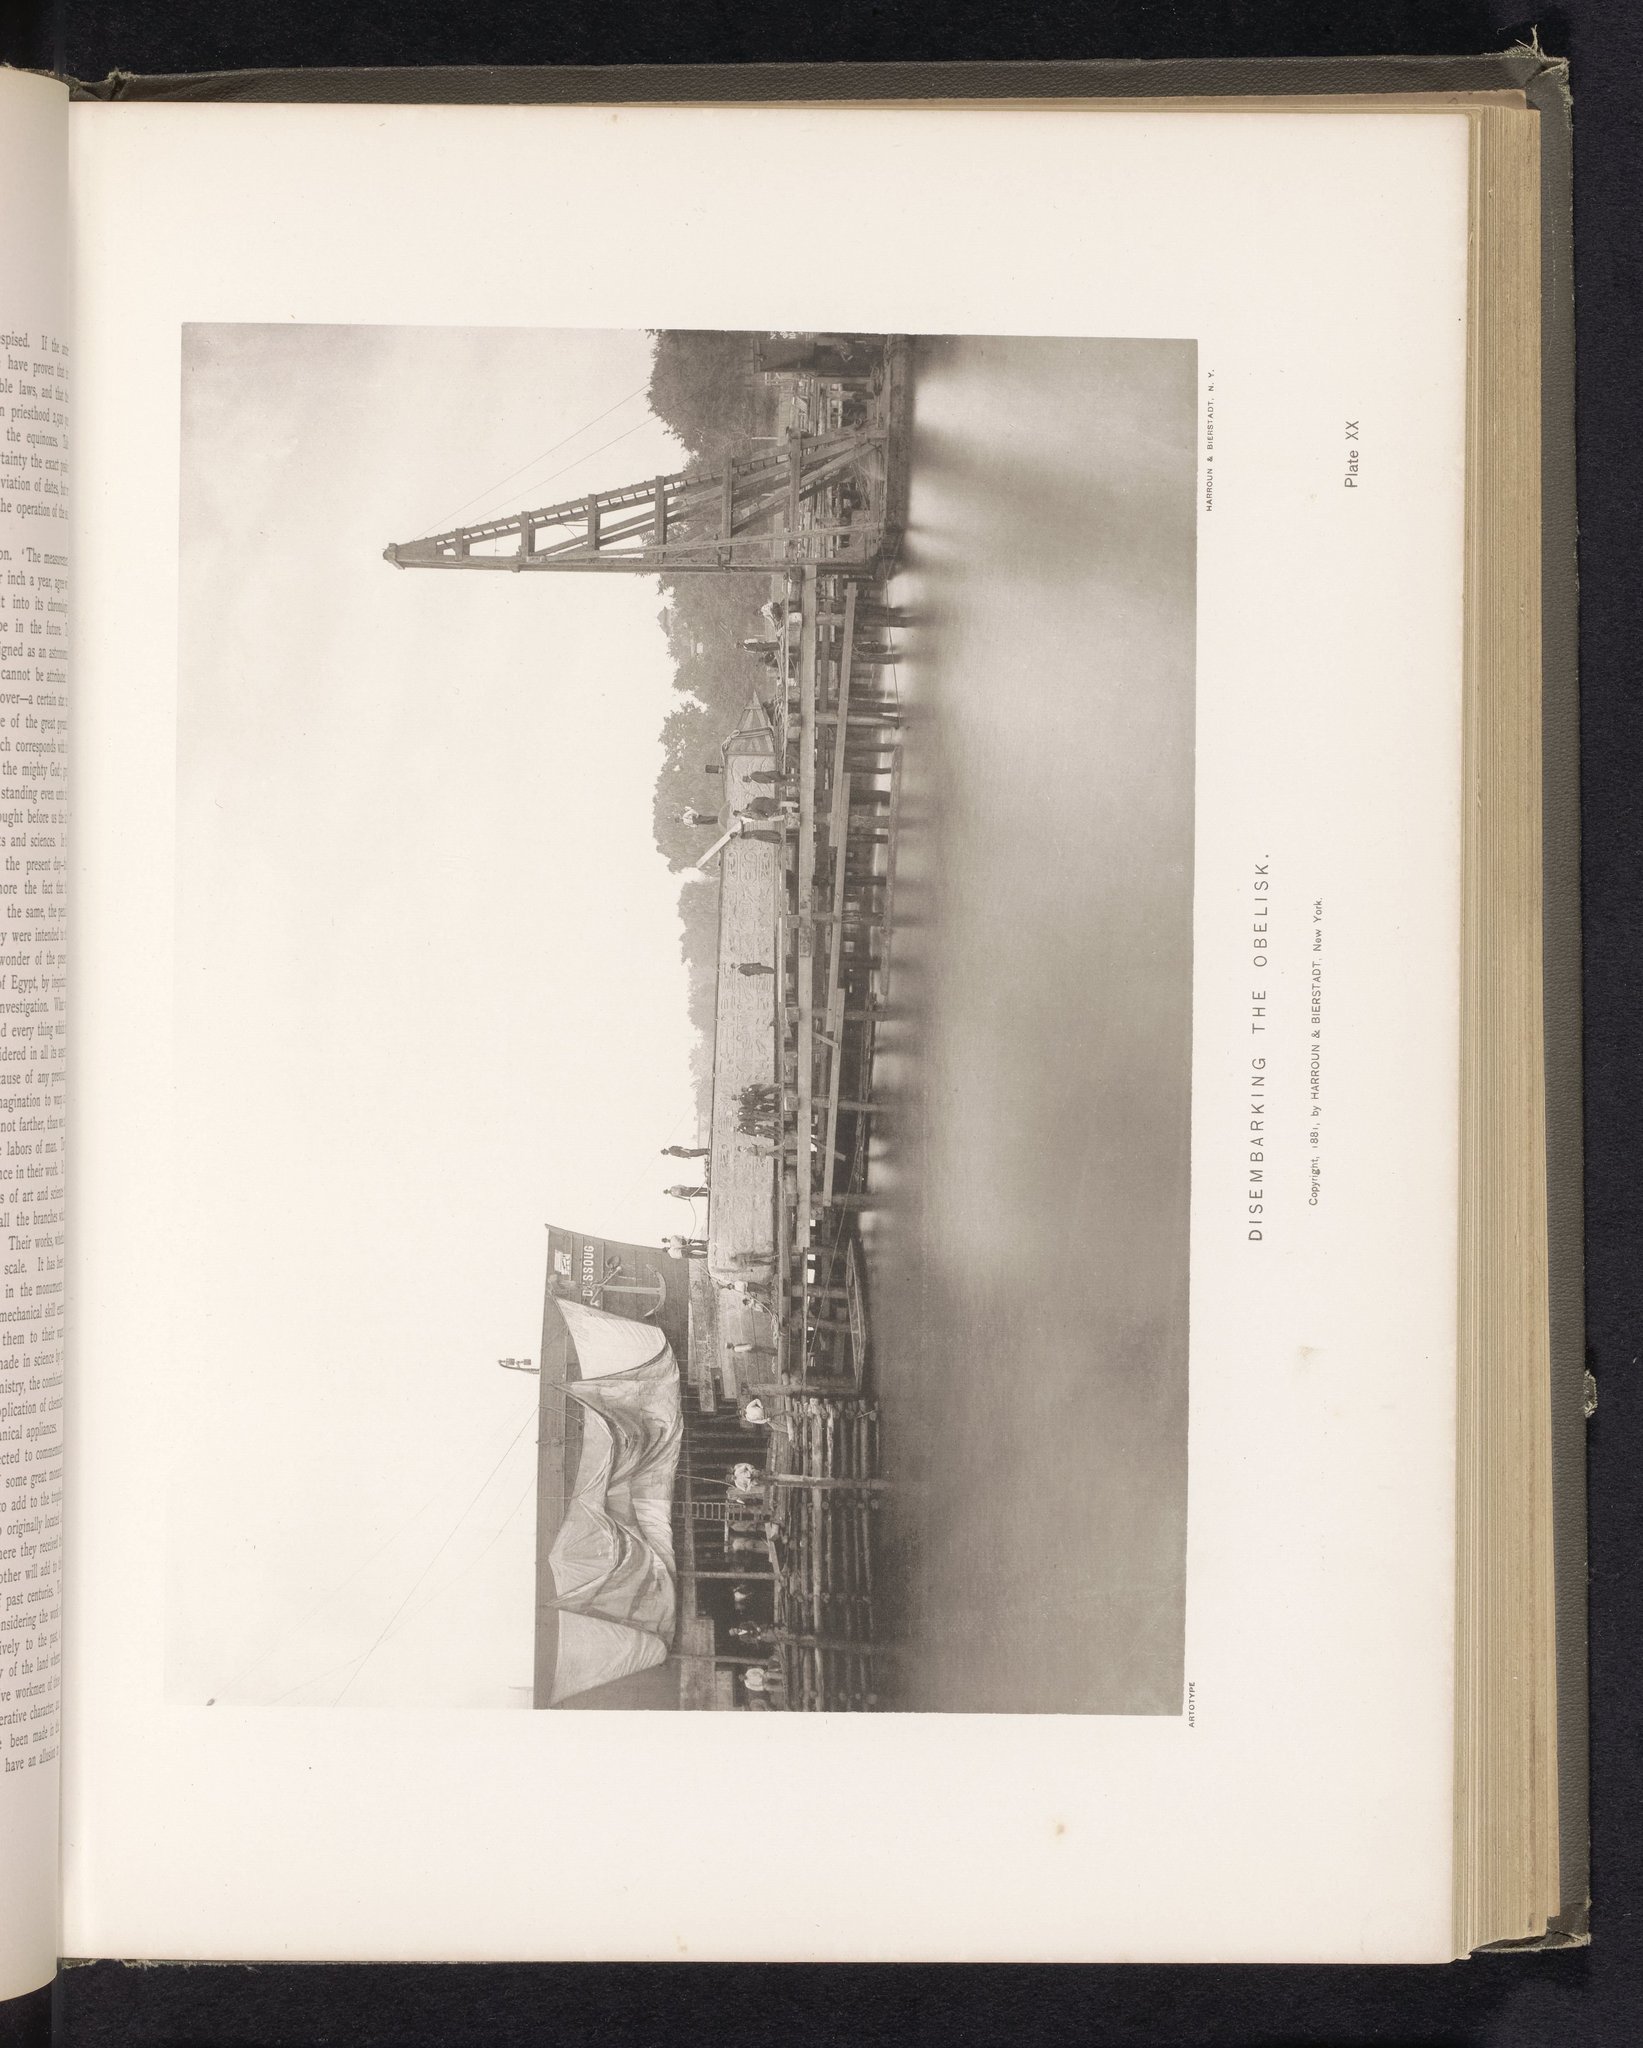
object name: photomechanical print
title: Disembarking the obelisk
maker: Anonymous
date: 1880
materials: paper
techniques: photograph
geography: new york city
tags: obelisk, needle, pier, quay, wharf, steamship, motorship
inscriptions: inscription: ‘Copyright 1881, by HARROUN & BIERSTADT, New York’, number: ‘Plate XX’